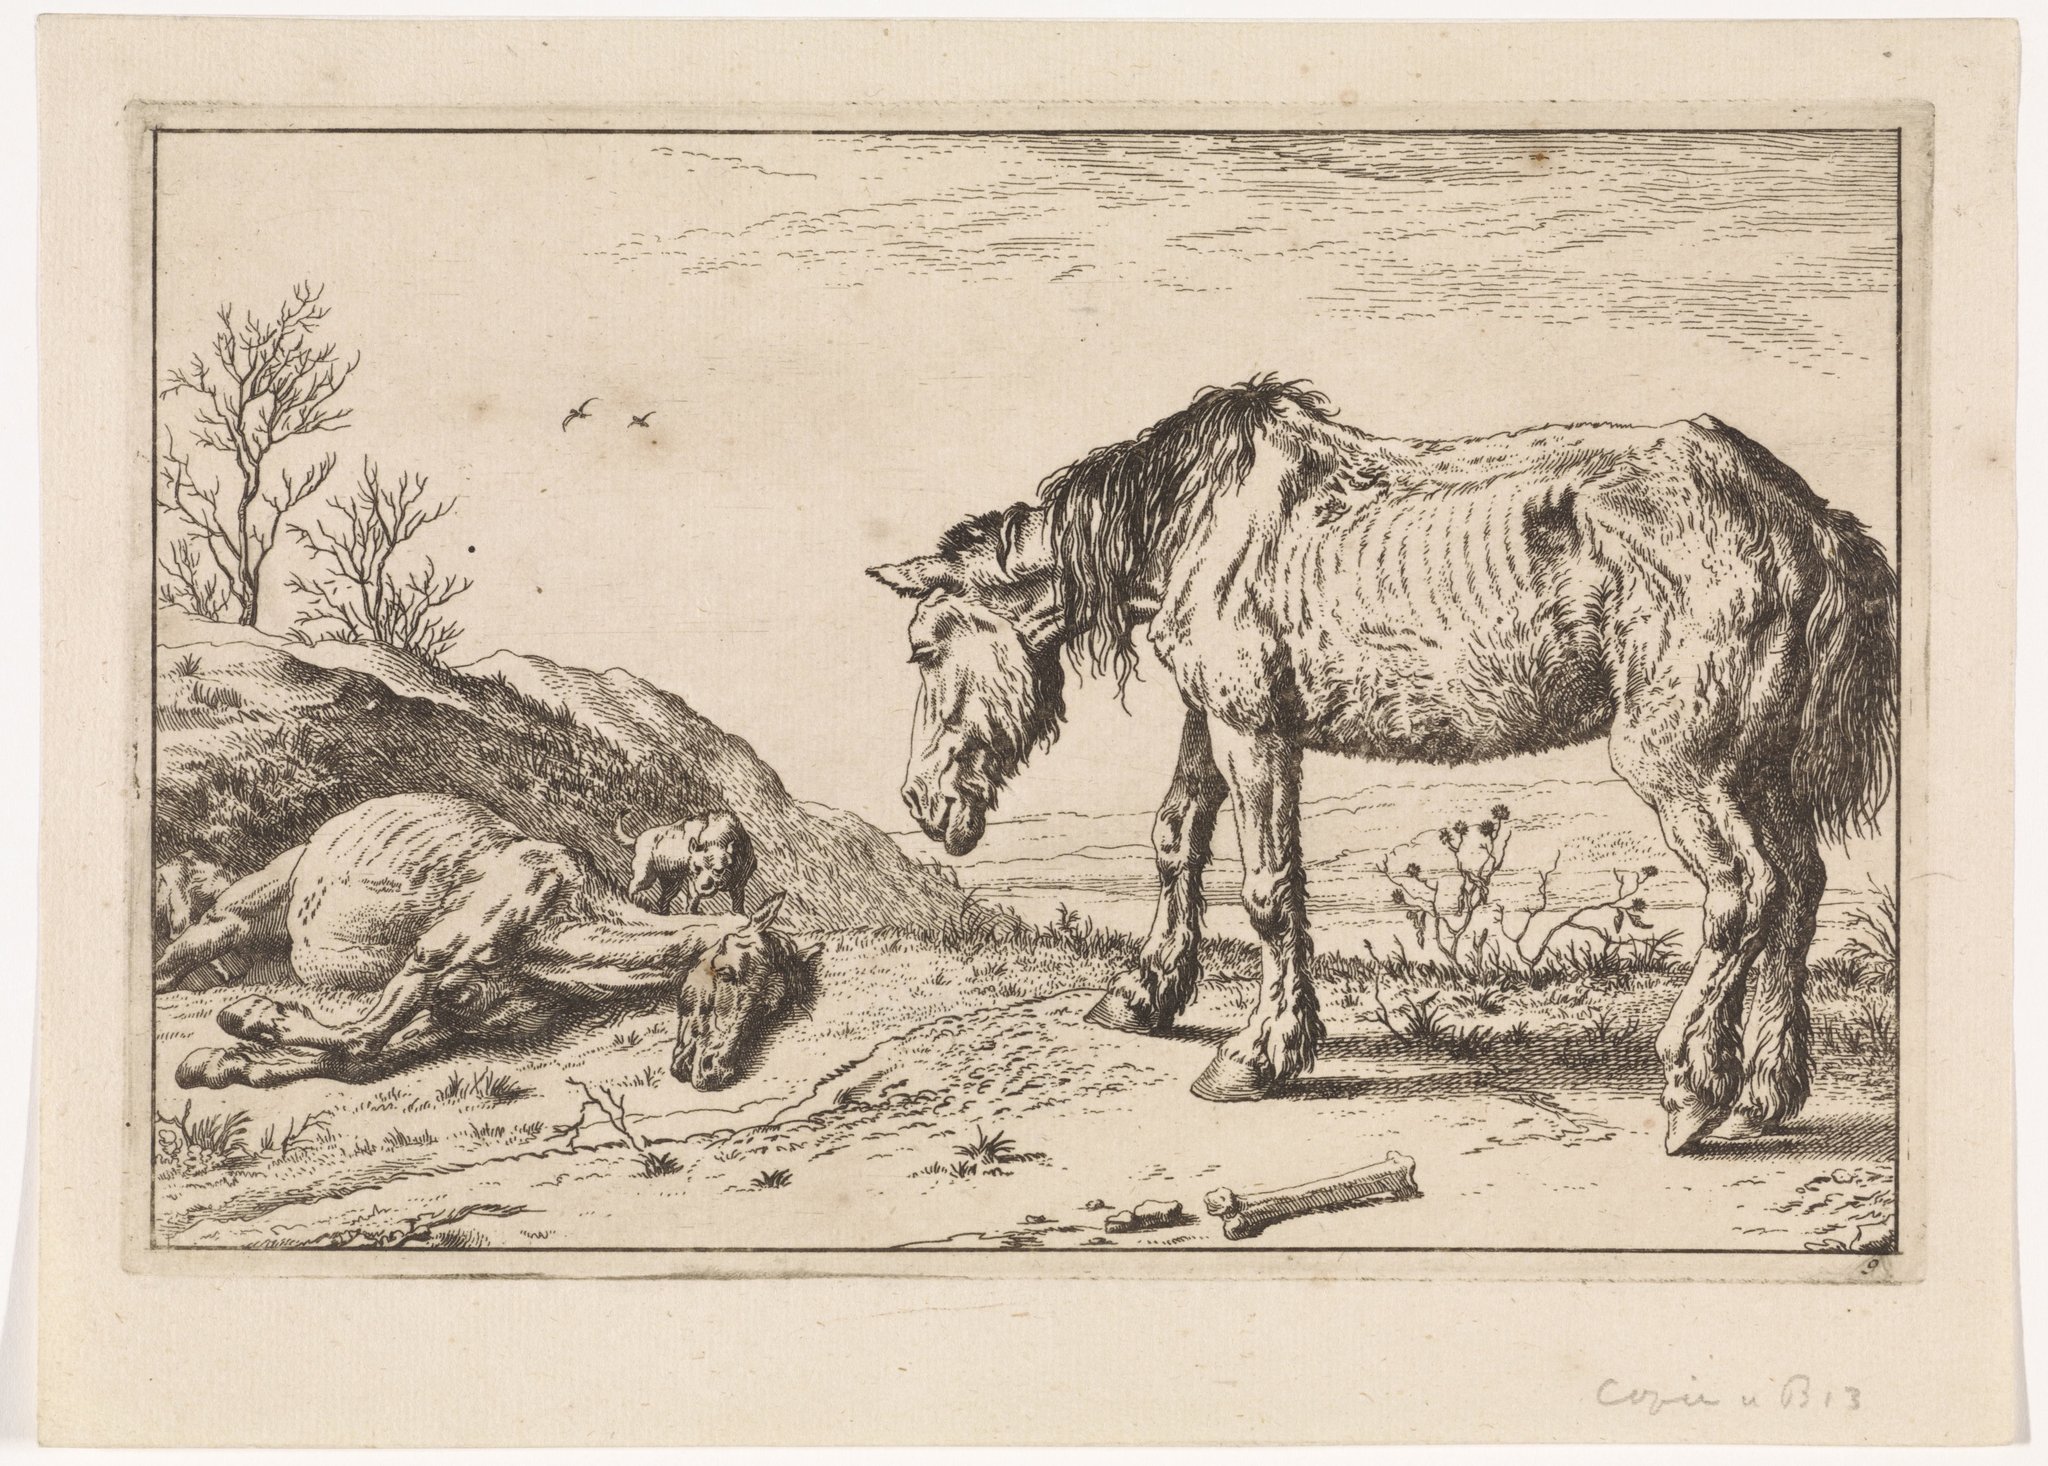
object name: print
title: Paarden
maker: Anonymous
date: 1652-1702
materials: paper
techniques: etching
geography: netherlands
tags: animals (+ dying animal; death of animal; dead animal), horse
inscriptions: collector's mark: Lugt 2228